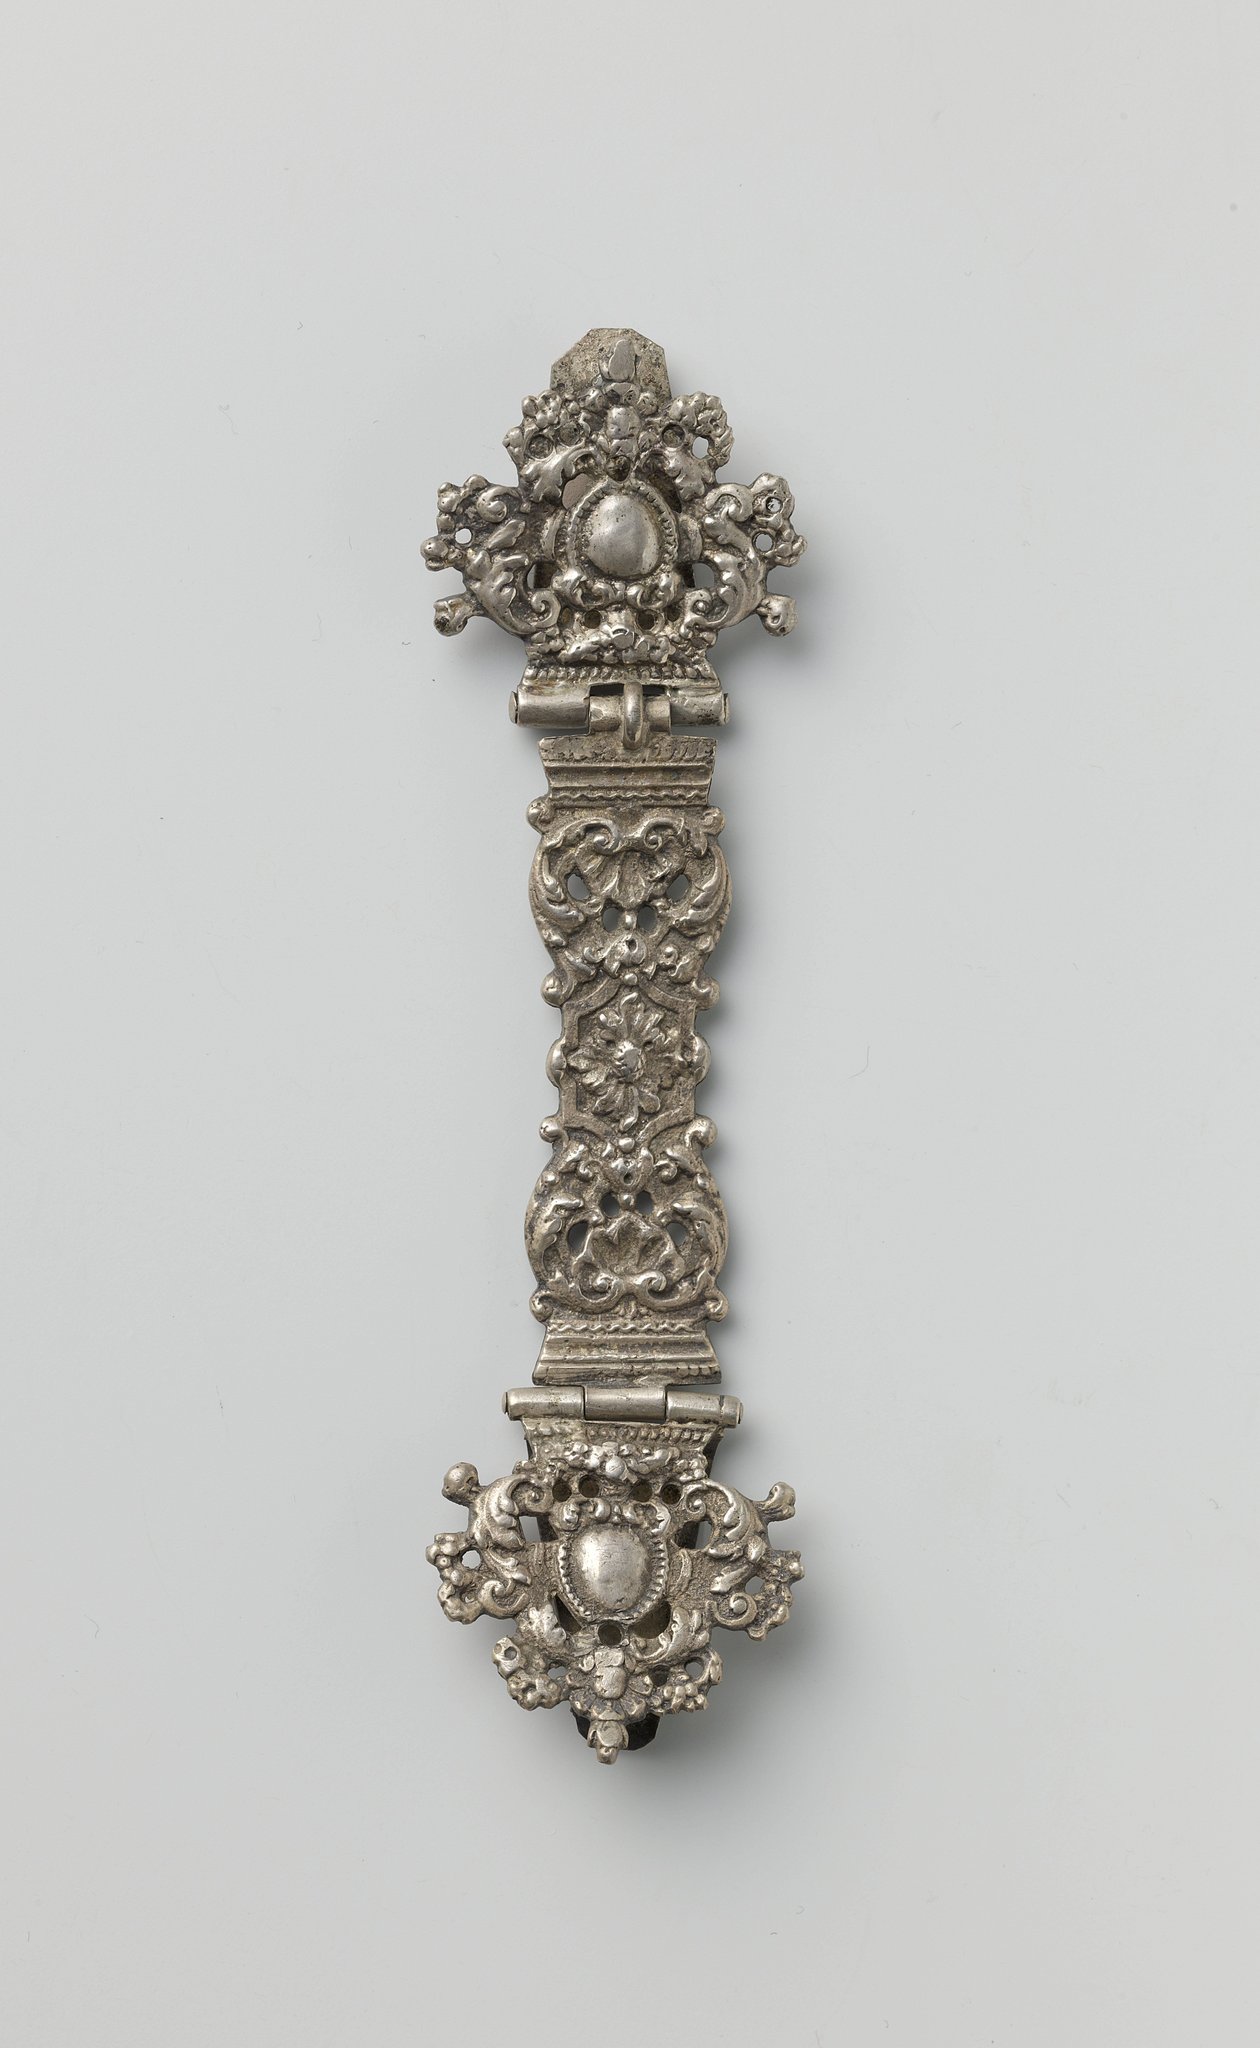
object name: boekslot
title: Boekslot van zilver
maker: Anonymous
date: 1800-1900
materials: silver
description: Boekslot van zilver, met getekend merkteken.